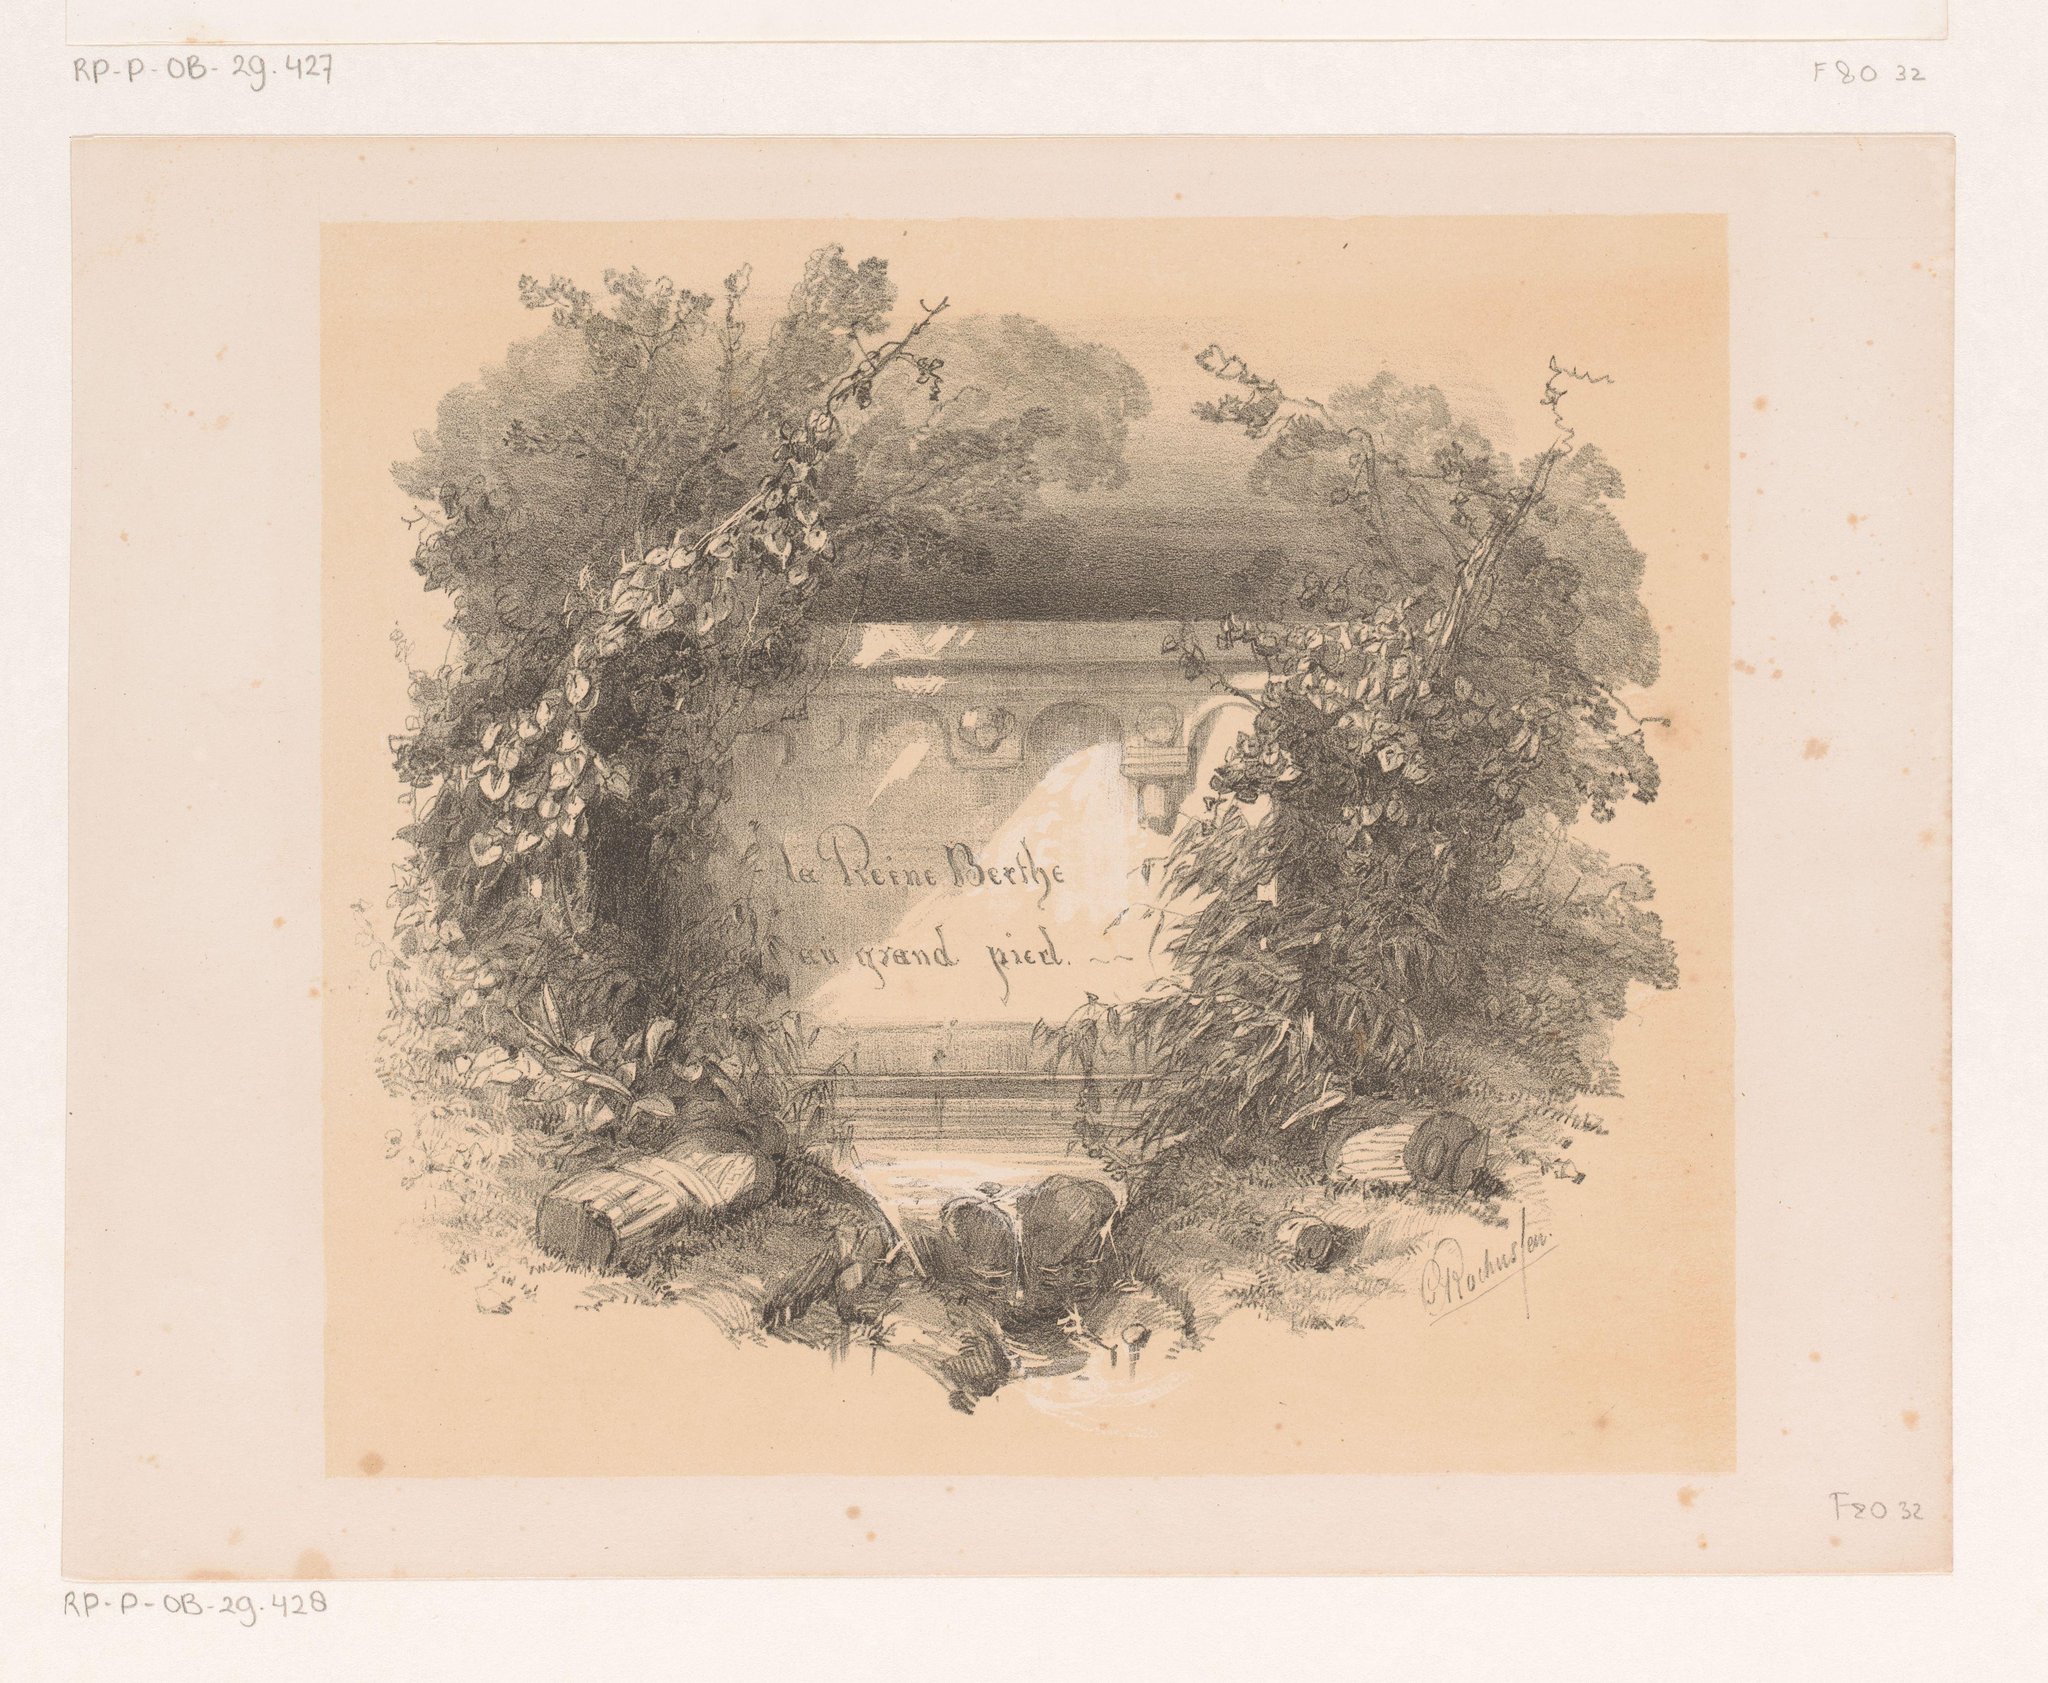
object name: titelblad, titelpagina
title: Titel op muur in landschap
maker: charles rochussen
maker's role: draughtsman, painter, print maker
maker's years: 1814-1894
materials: paper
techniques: tone lithography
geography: the hague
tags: landscapes, fence, wall, paling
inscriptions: collector's mark: Lugt 2228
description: Titelpagina voor: Plancy, Jacques Collin de. La Reine Berthe au grand pied. Den Haag: Nederlandsche Maatschappij van Schoone Kunsten, 1842.